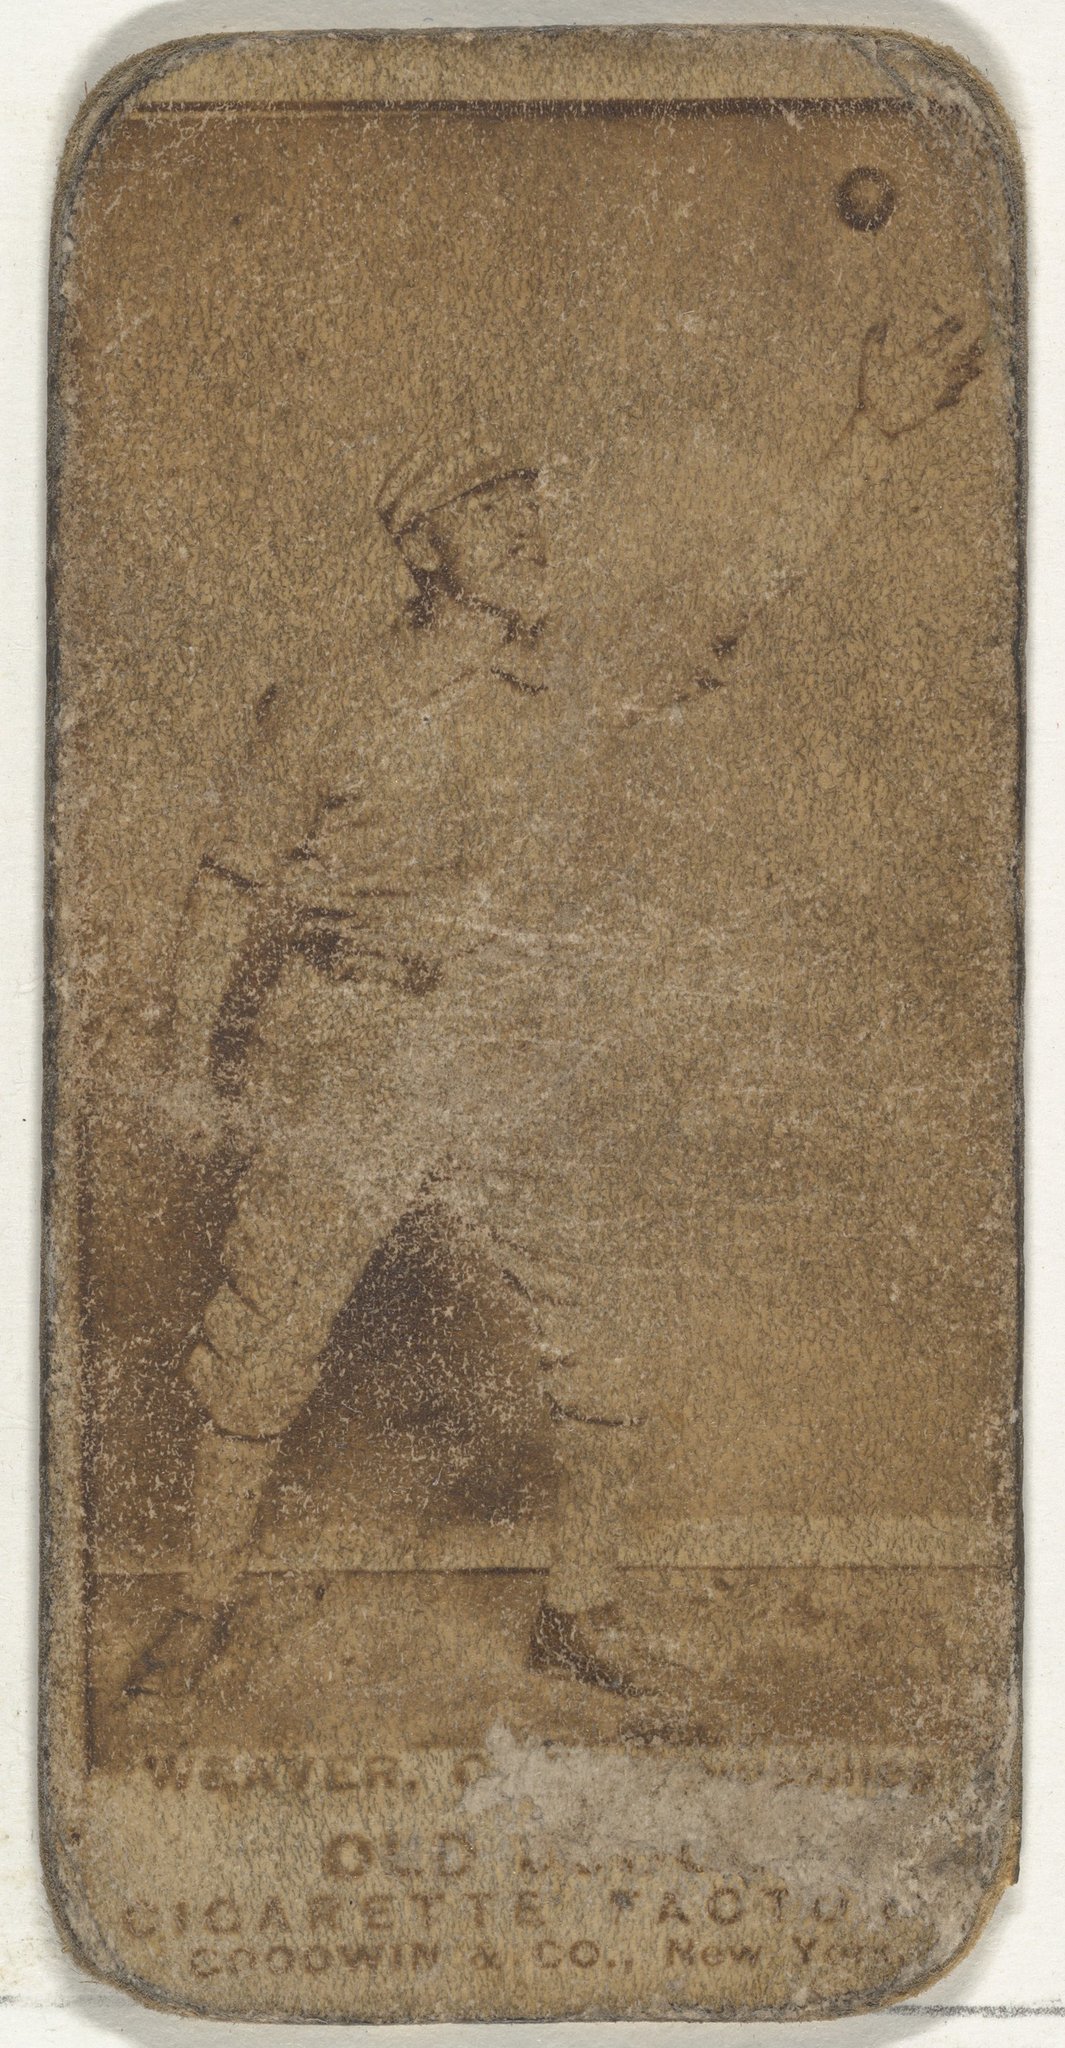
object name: baseball card, photograph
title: William B. "Farmer" Weaver, Center Field, Louisville Colonels, from the Old Judge series (N172) for Old Judge Cigarettes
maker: goodwin & company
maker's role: publisher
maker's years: 1850-1950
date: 1887-1890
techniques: albumen silver print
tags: men,portraits,baseball,athletes